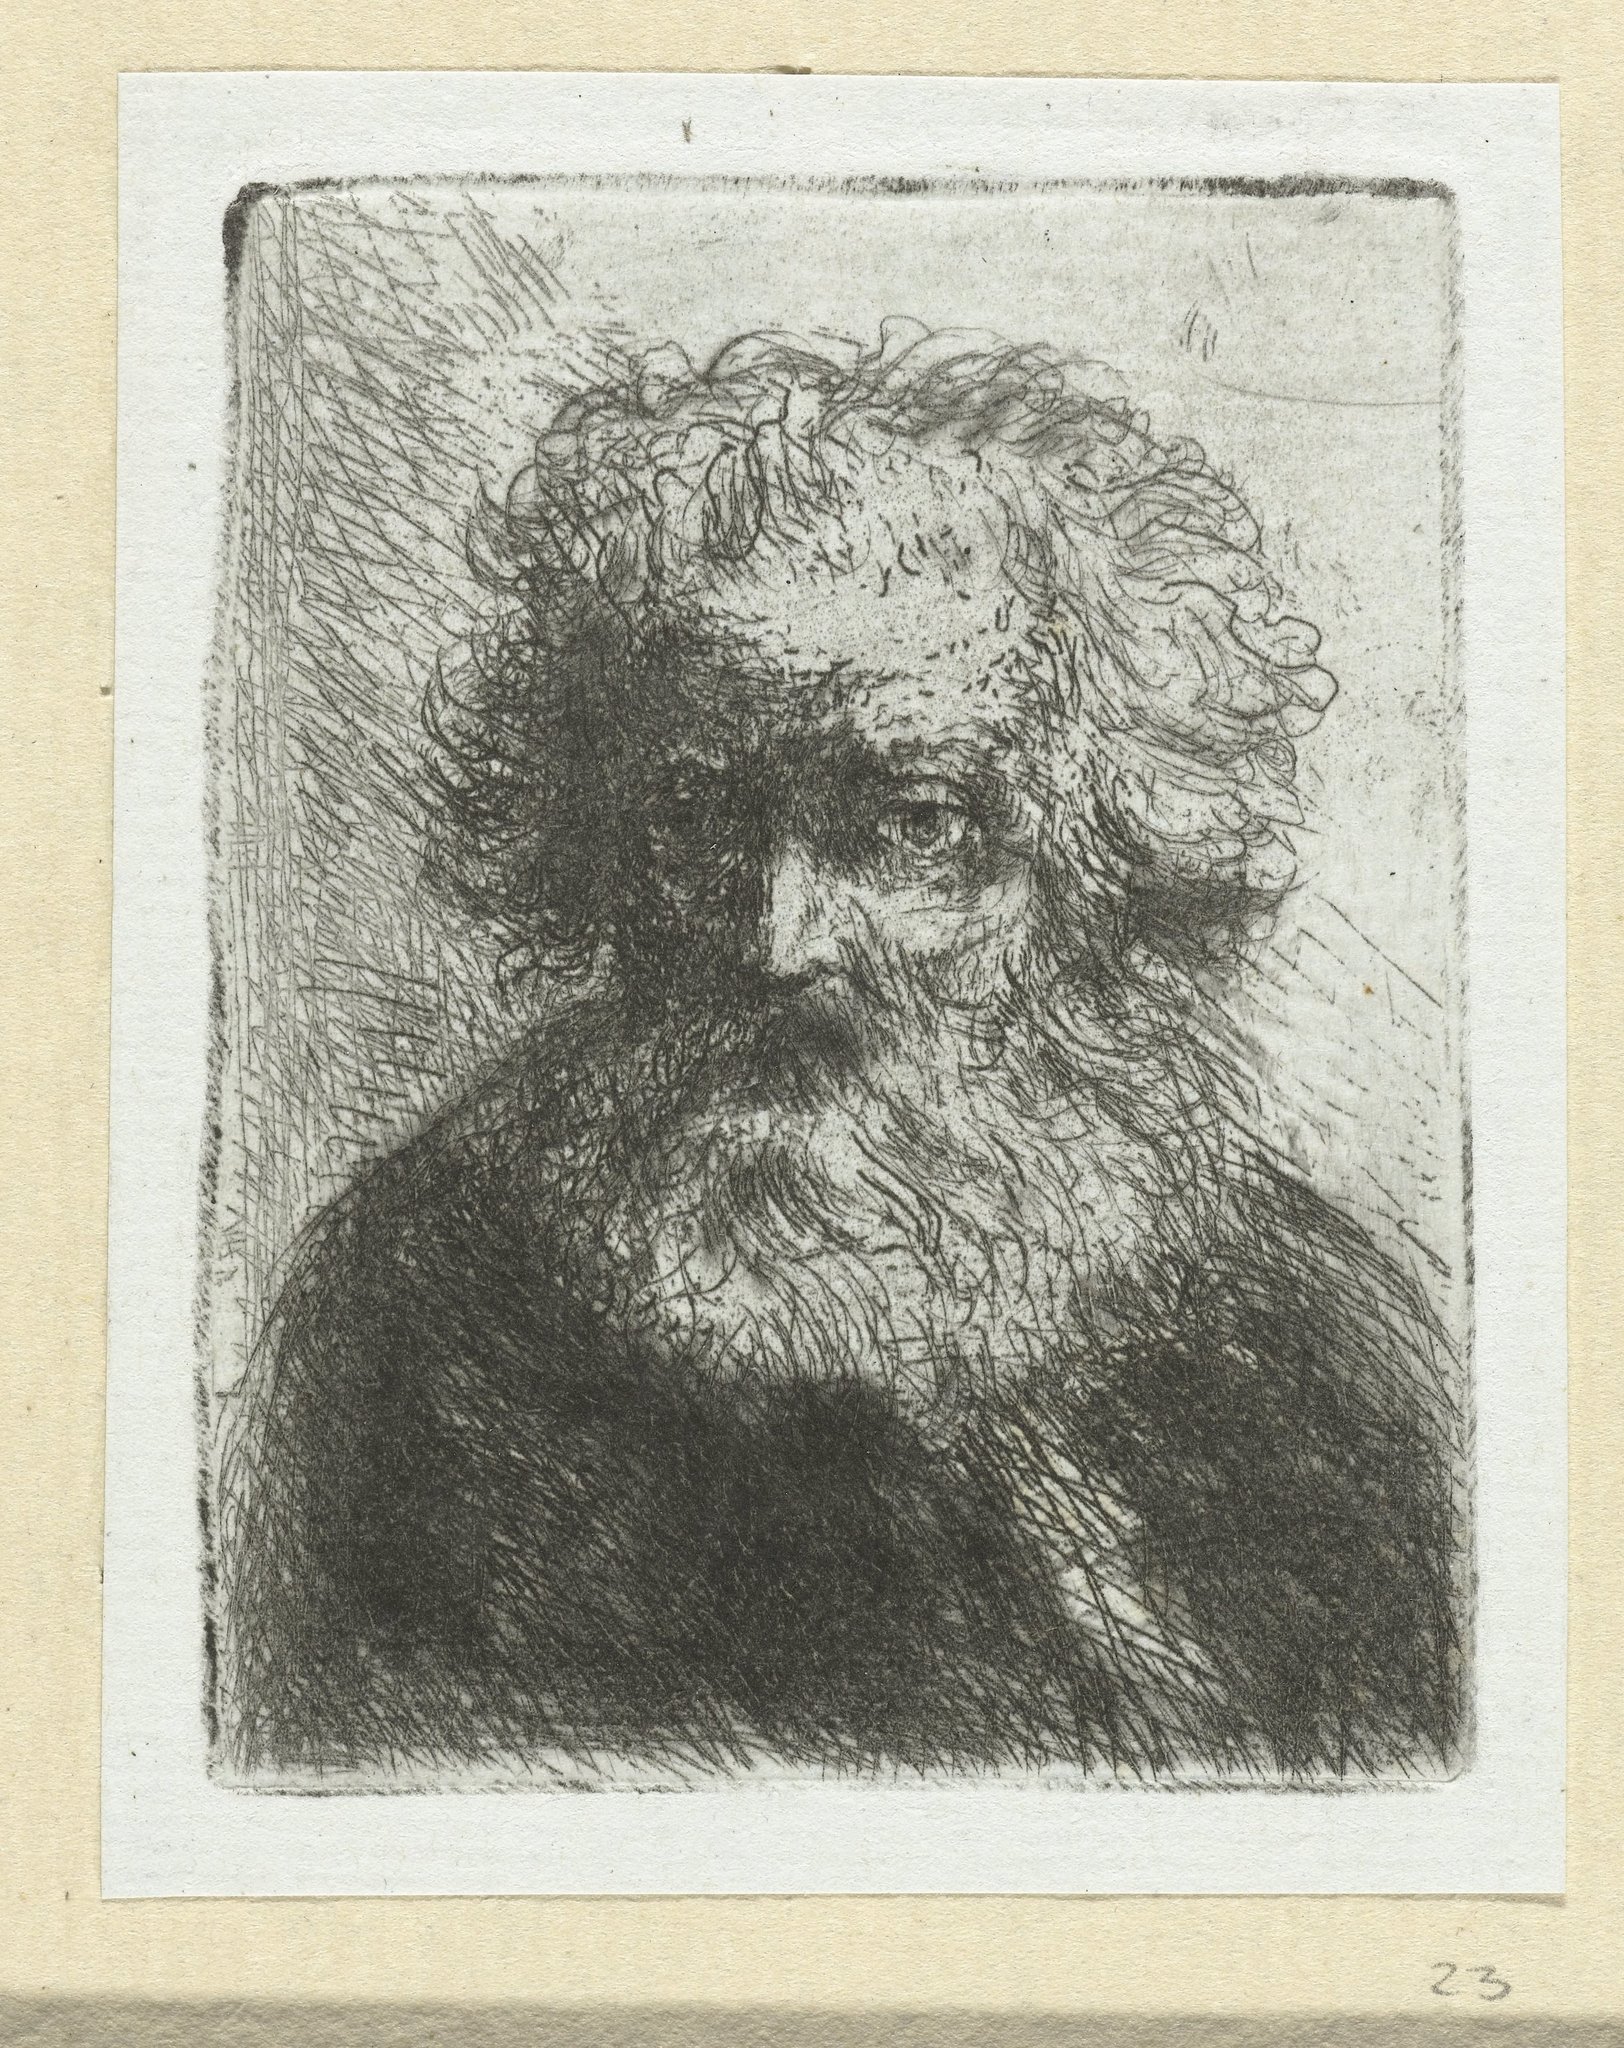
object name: print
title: Bebaarde oude man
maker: jan chalon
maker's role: print maker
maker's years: 1738-1795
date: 1748-1795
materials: paper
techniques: drypoint, etching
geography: northern netherlands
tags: morphology of human expression (+ old male (human being))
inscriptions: collector's mark: Lugt 924